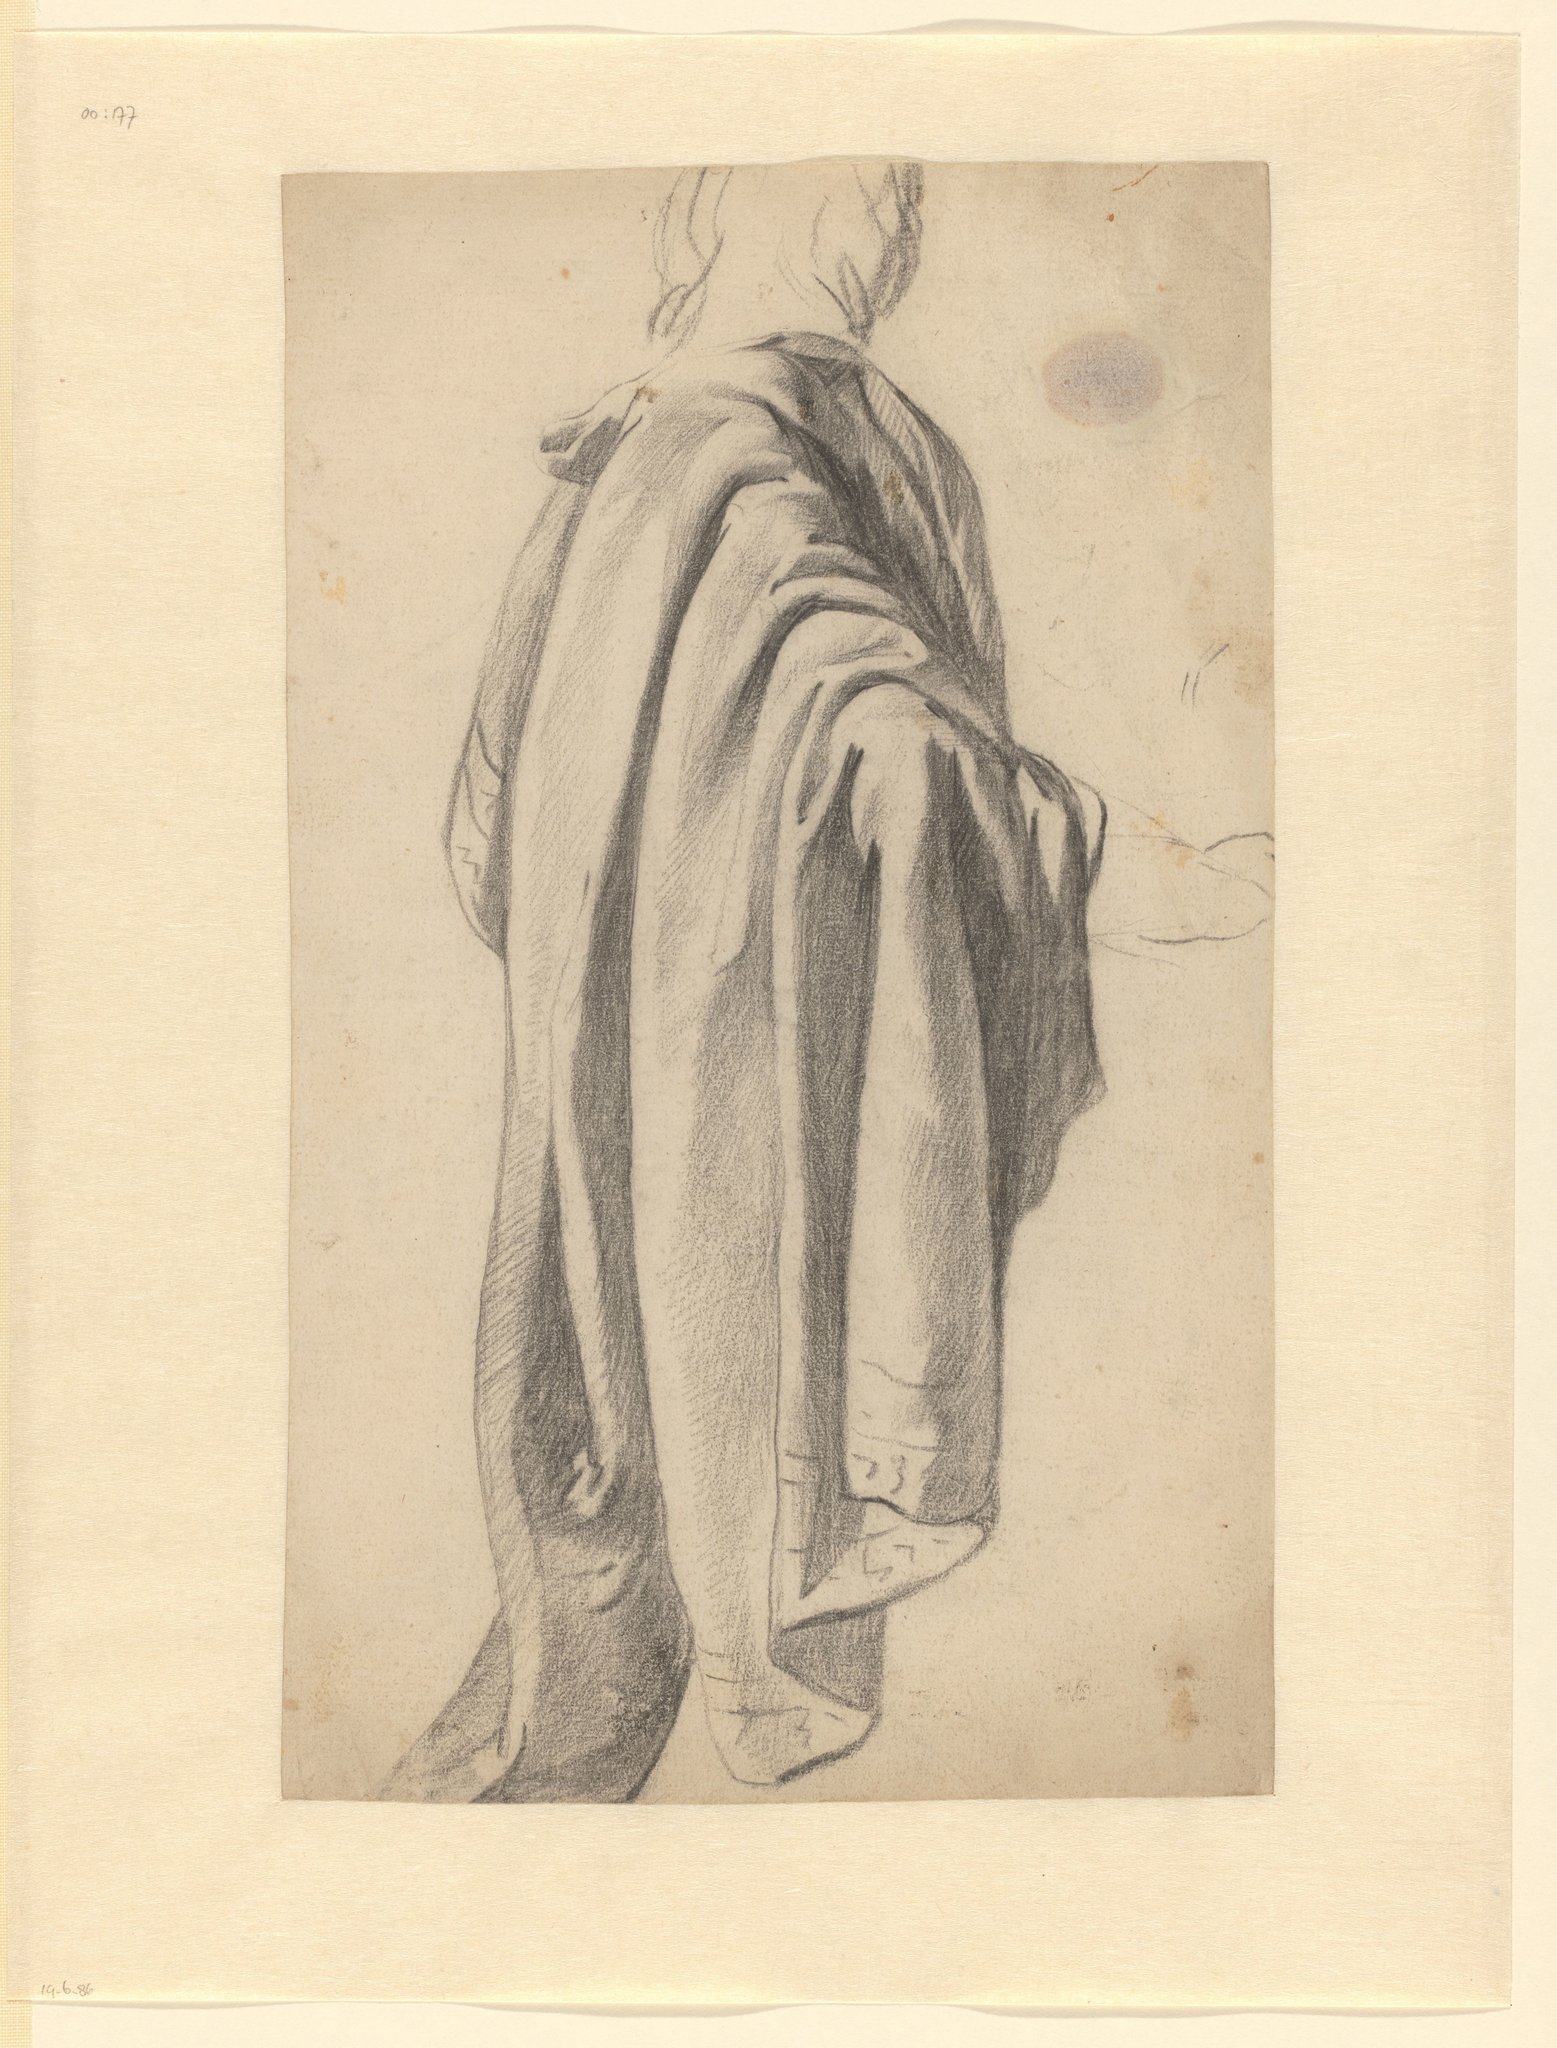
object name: drawing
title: Studie van een mantel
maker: peter lely (sir)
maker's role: draughtsman, painter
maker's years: 1618-1680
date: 1628-1680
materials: chalk, paper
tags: coat (+ men's clothes), drapery, draped garment, 'gewandgebung'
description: Afkomstig uit een tekeningenalbum met onder andere figuur- en handstudies van of naar Caspar en Constantijn Netscher (BI-1894-3720). Tekening bevond zich oorspronkelijk op f. 42.